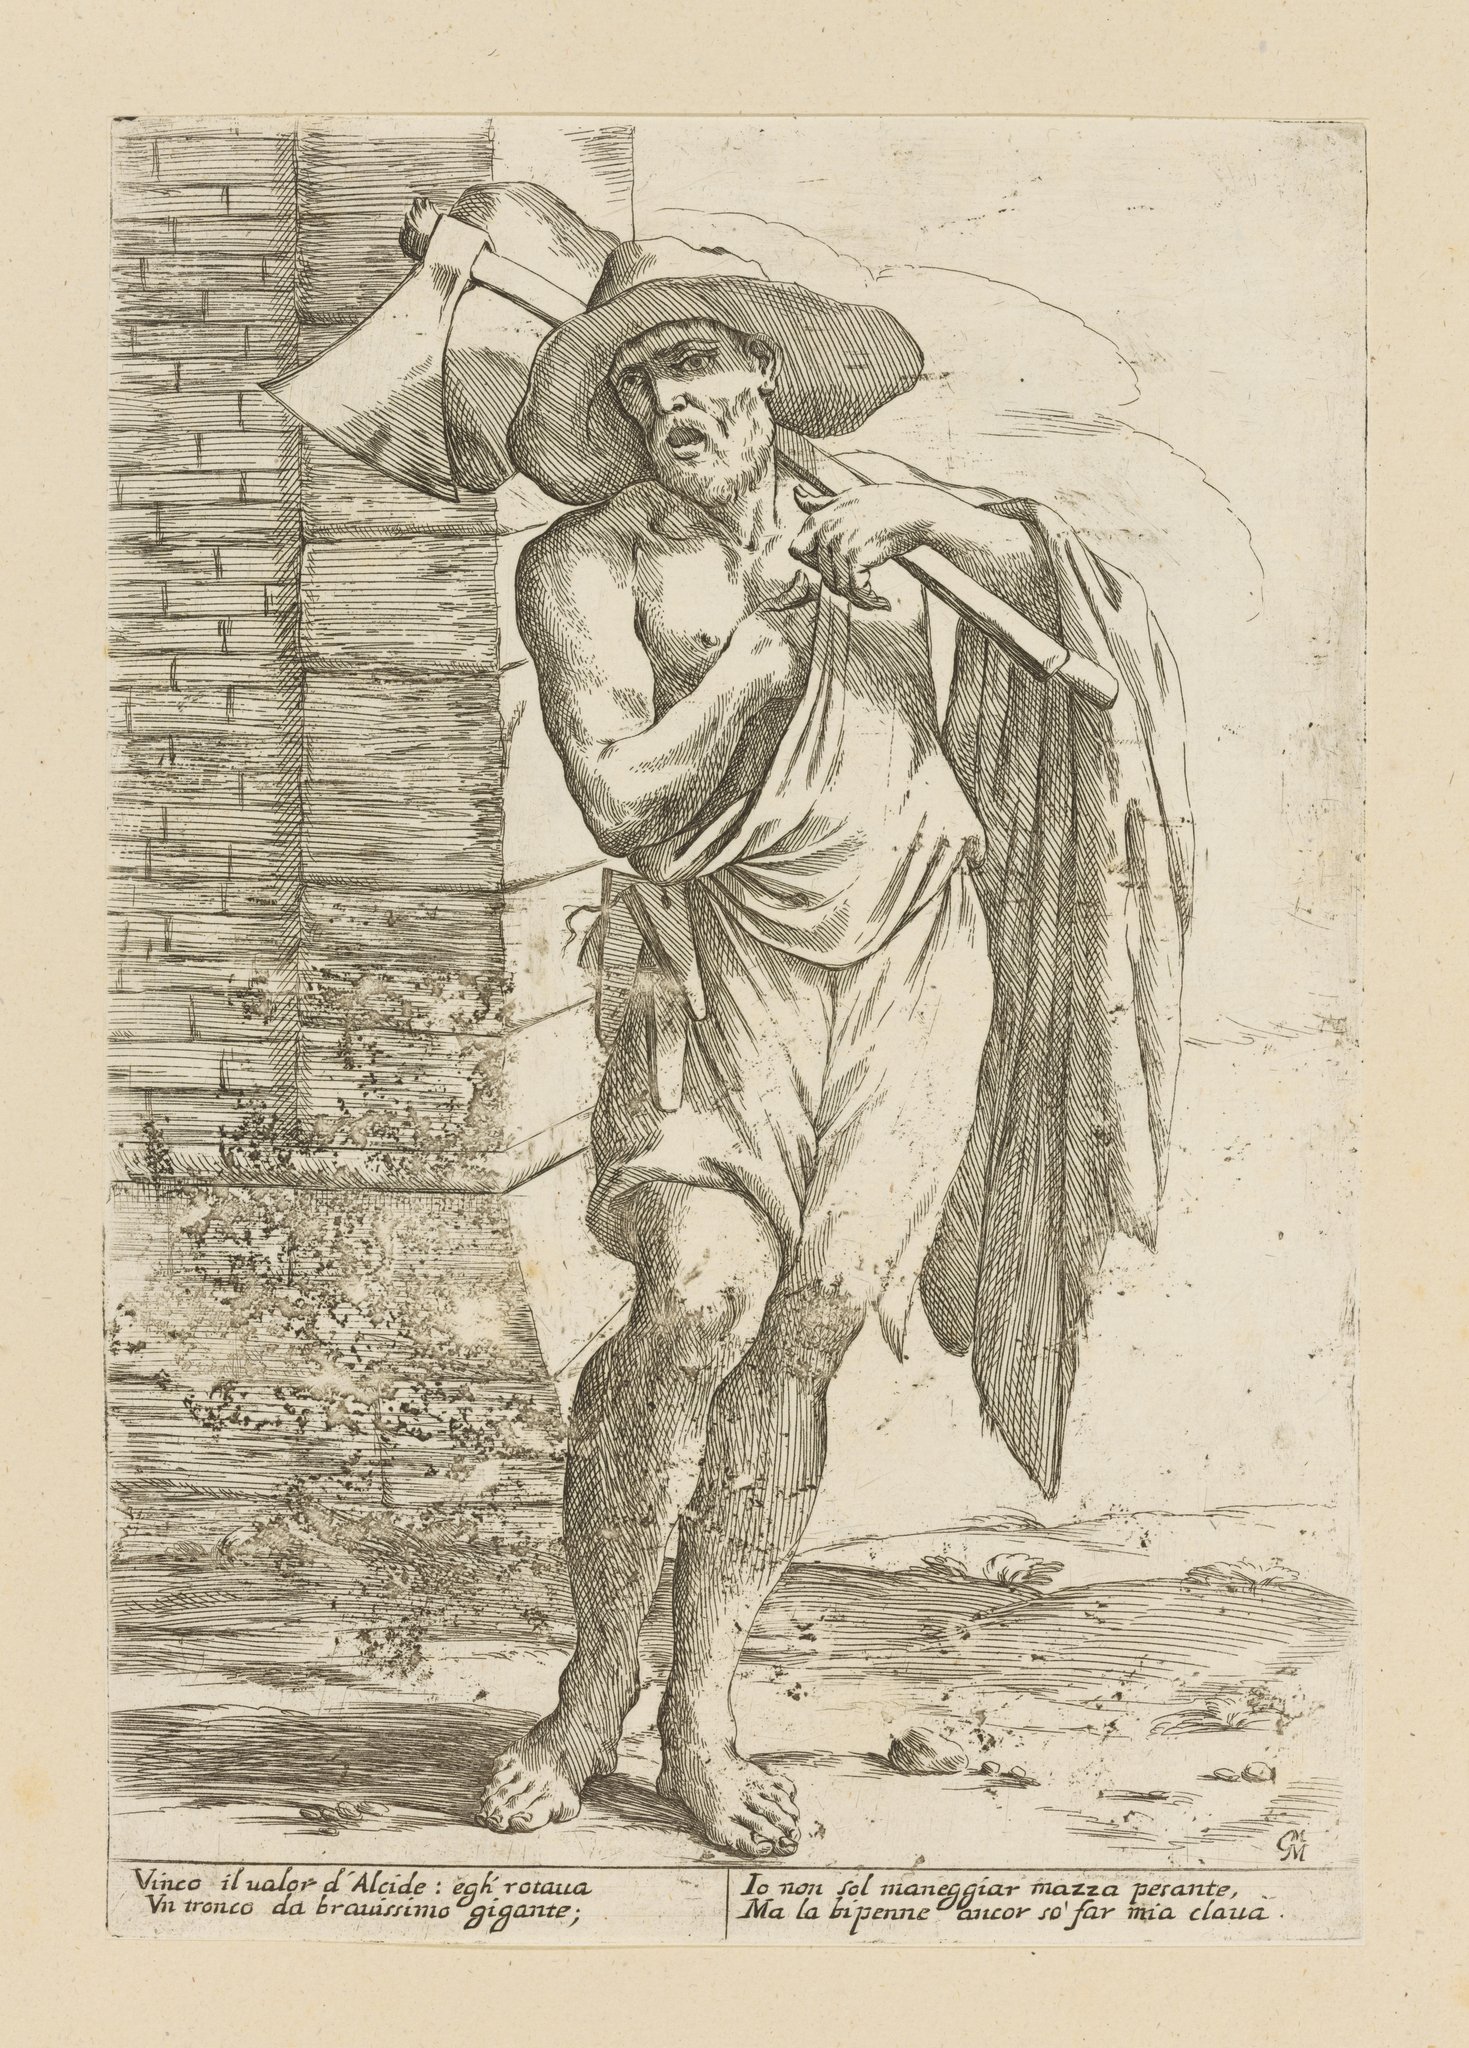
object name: print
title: Woodcutter, from Di Bologna l'Arti per via D'An.ibal' Ca.rac, plate 29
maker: giuseppe maria mitelli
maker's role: artist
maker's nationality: italian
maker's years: 1634-1718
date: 1660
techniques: etching